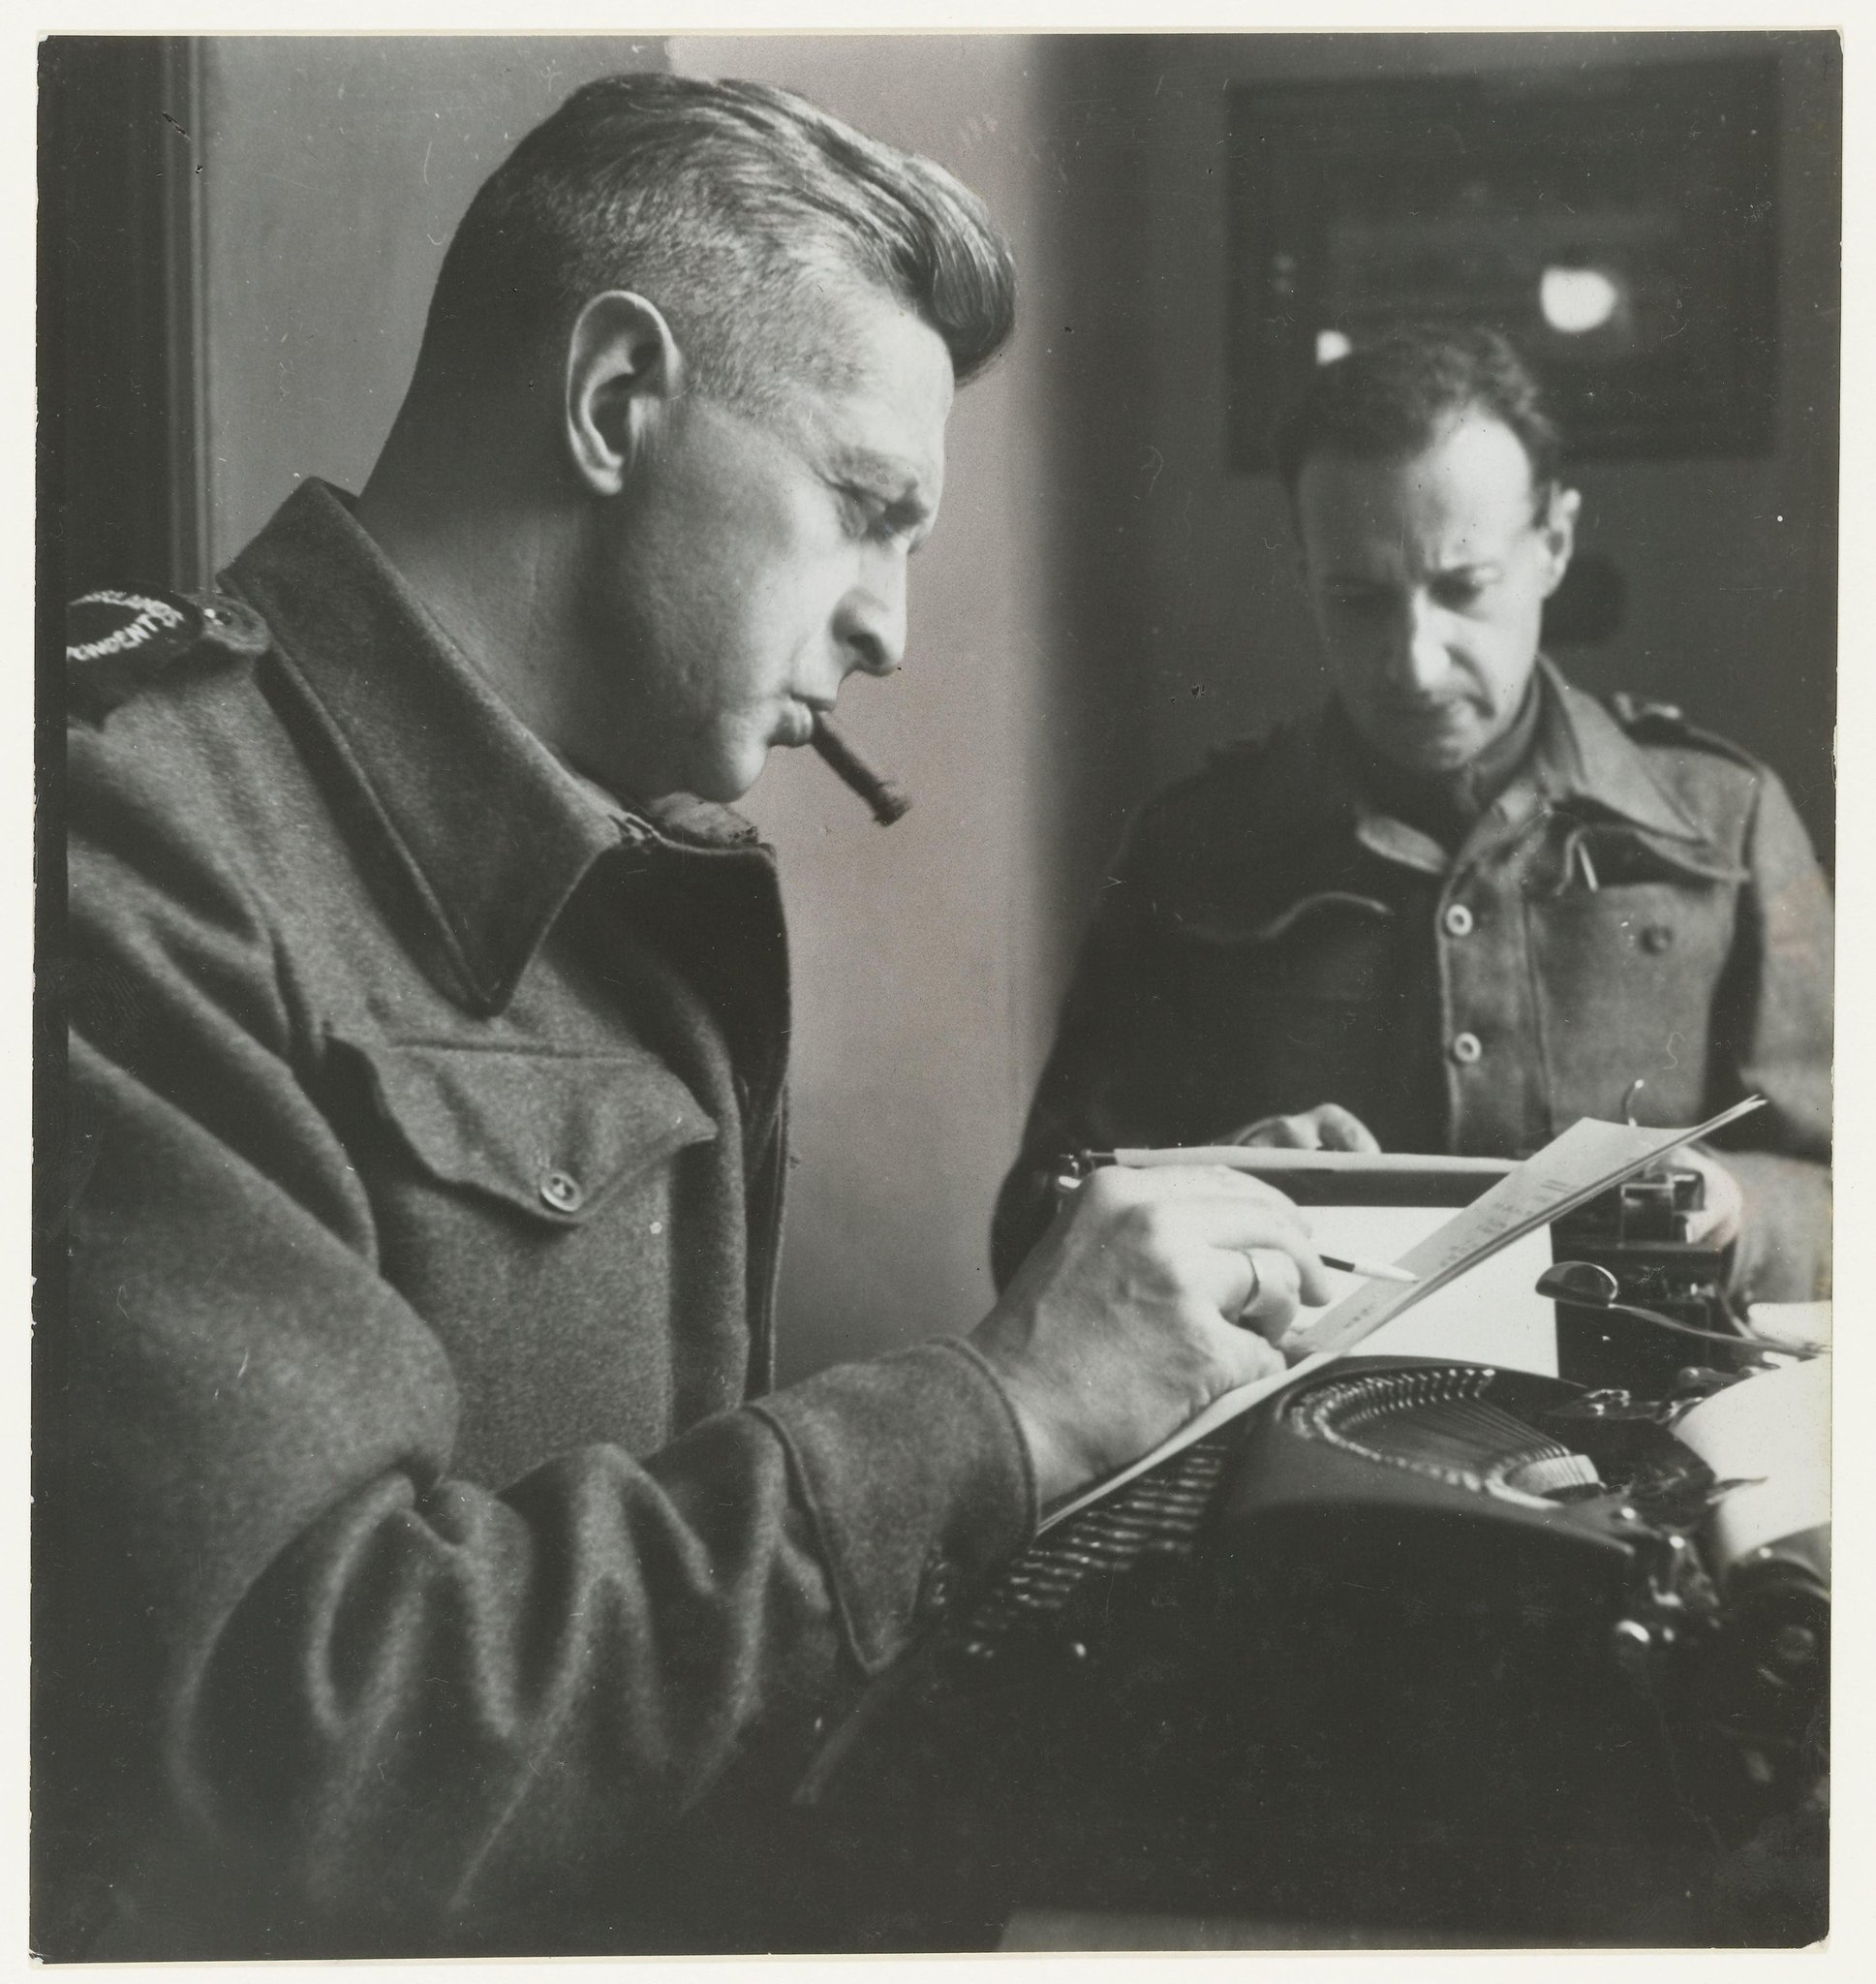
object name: documentary photograph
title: Twee journalisten corrigeren teksten in perscentrum te Neurenberg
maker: Anonymous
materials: photographic support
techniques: photography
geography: nuremberg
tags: publisher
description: Jan Stoffels, verslaggever van 'Herrijzend Nederland', corrigeert zijn teksten zittend aan een tafel achter een typemachine met een sigaar in de mond. Met rechtsachter hem de journalist Lissauer van het ANP die typt op zijn schrijfmachine. Beide heren zijn gekleed in militair tenue en verslaan de Neurenbergse processen vanuit het perscentrum. Dit centrum is gevestigd in kasteel Faber in het dorpje Stein nabij Neurenberg.